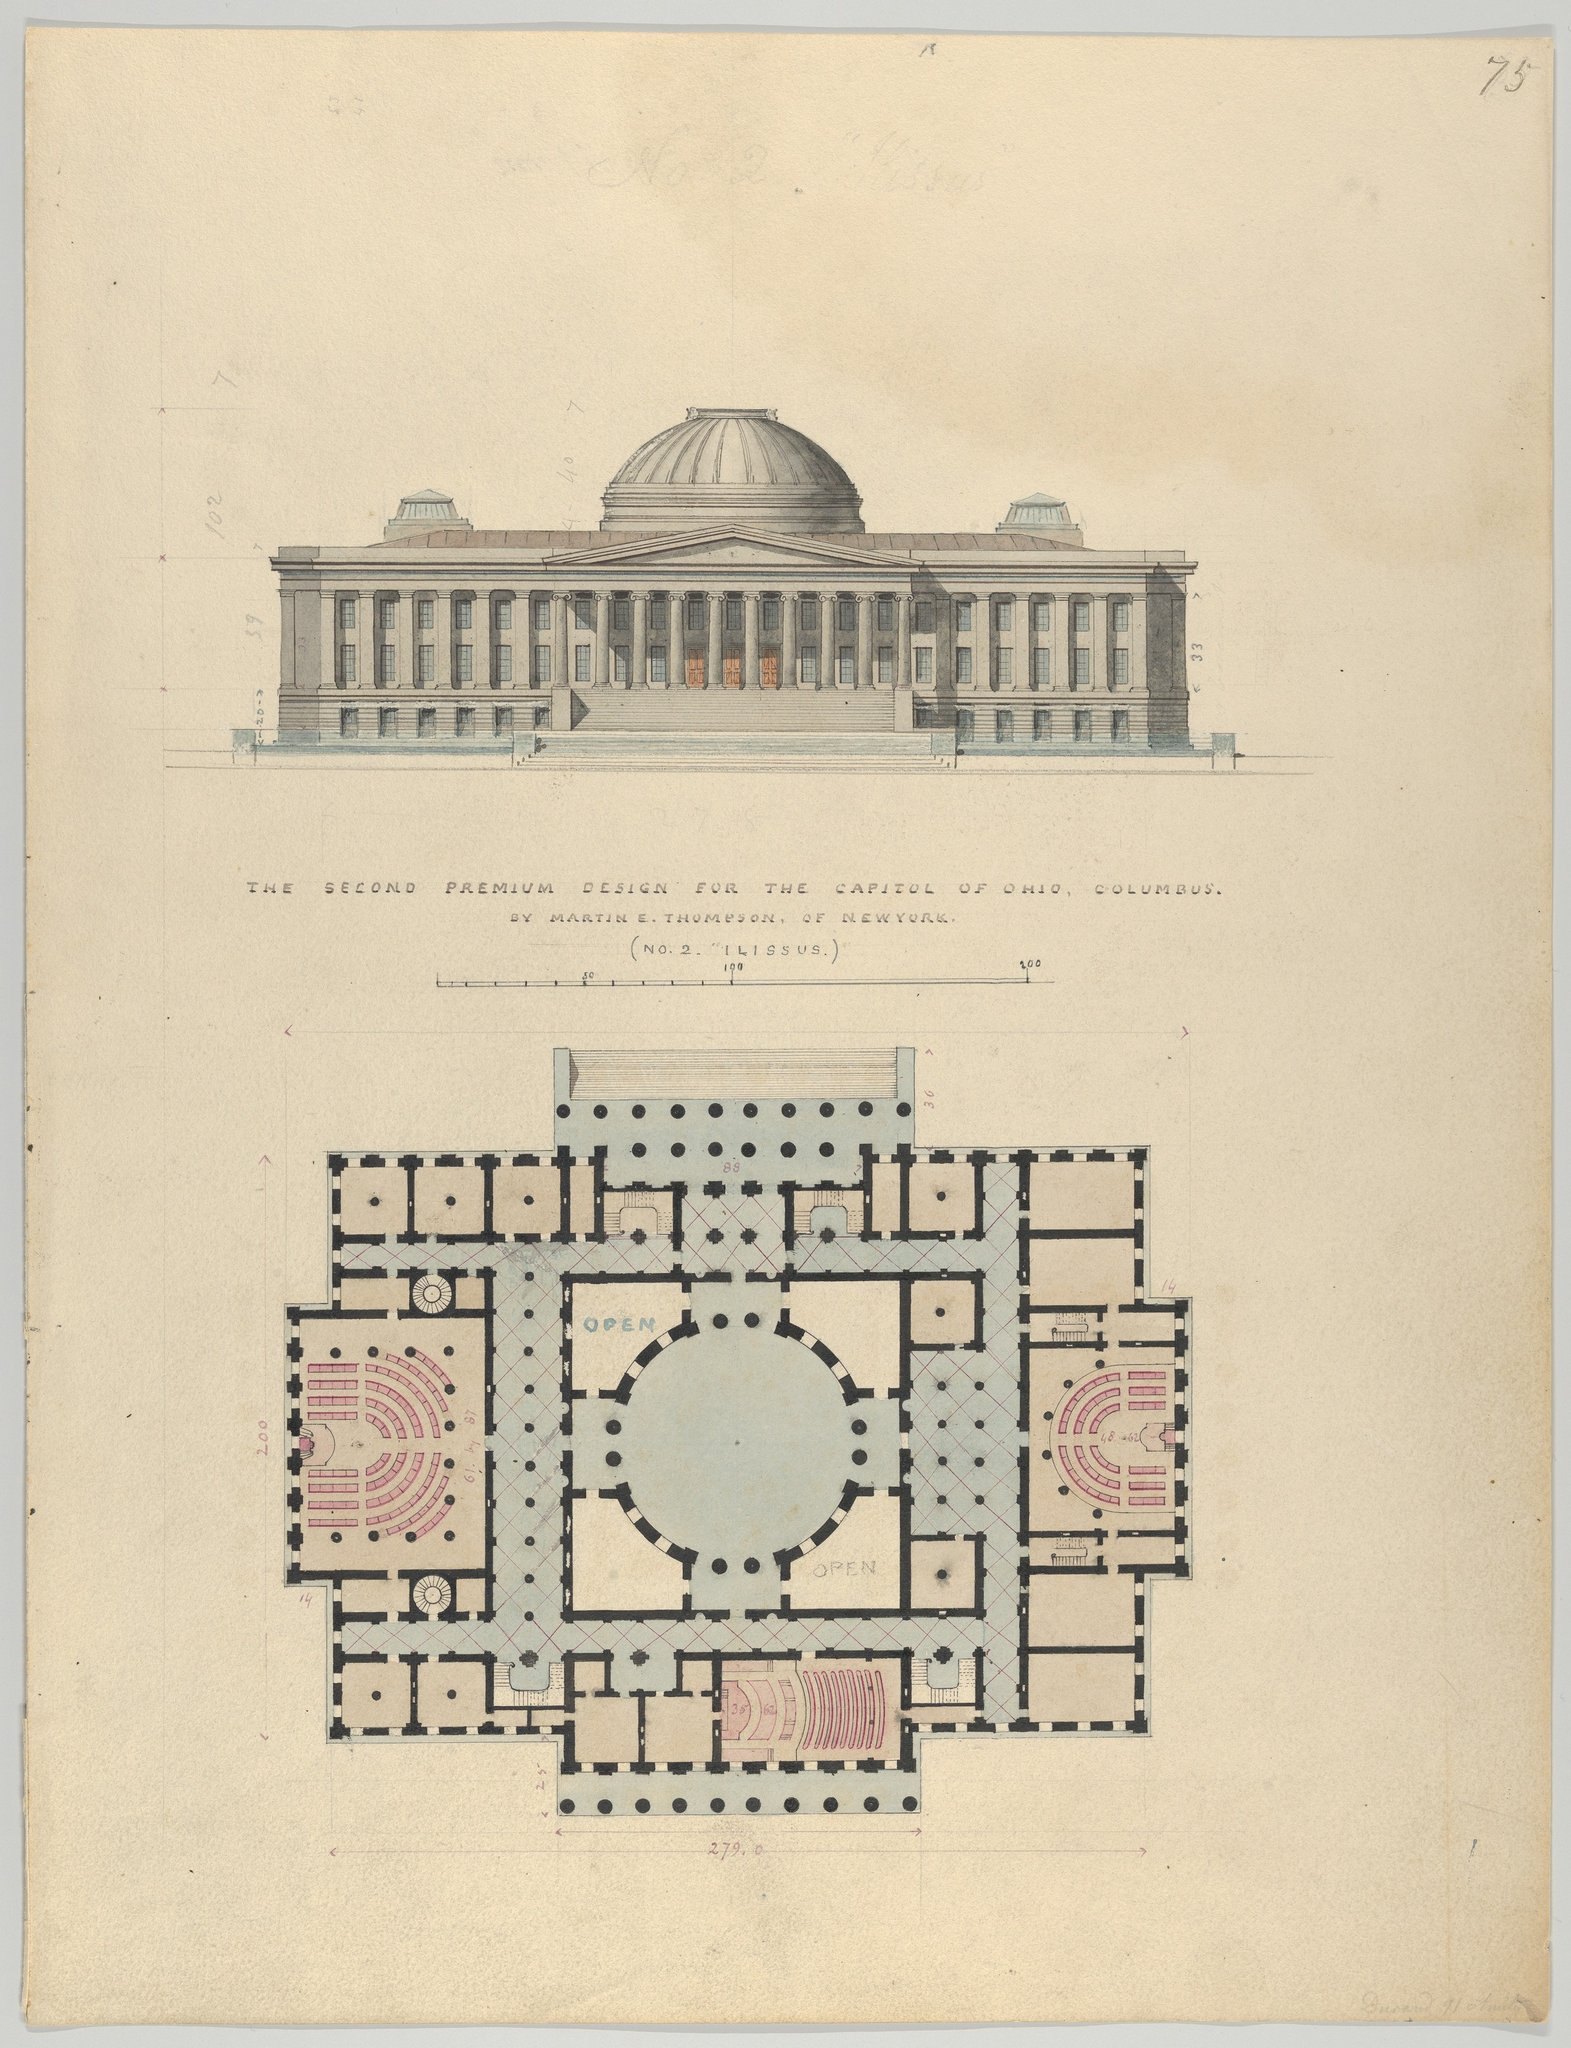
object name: drawing ornament architecture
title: The Second Premium Design for the Capitol of Ohio, Columbus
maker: alexander jackson davis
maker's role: artist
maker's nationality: american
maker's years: 1803-1892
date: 1839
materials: graphite, ink, watercolor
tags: architecture,buildings